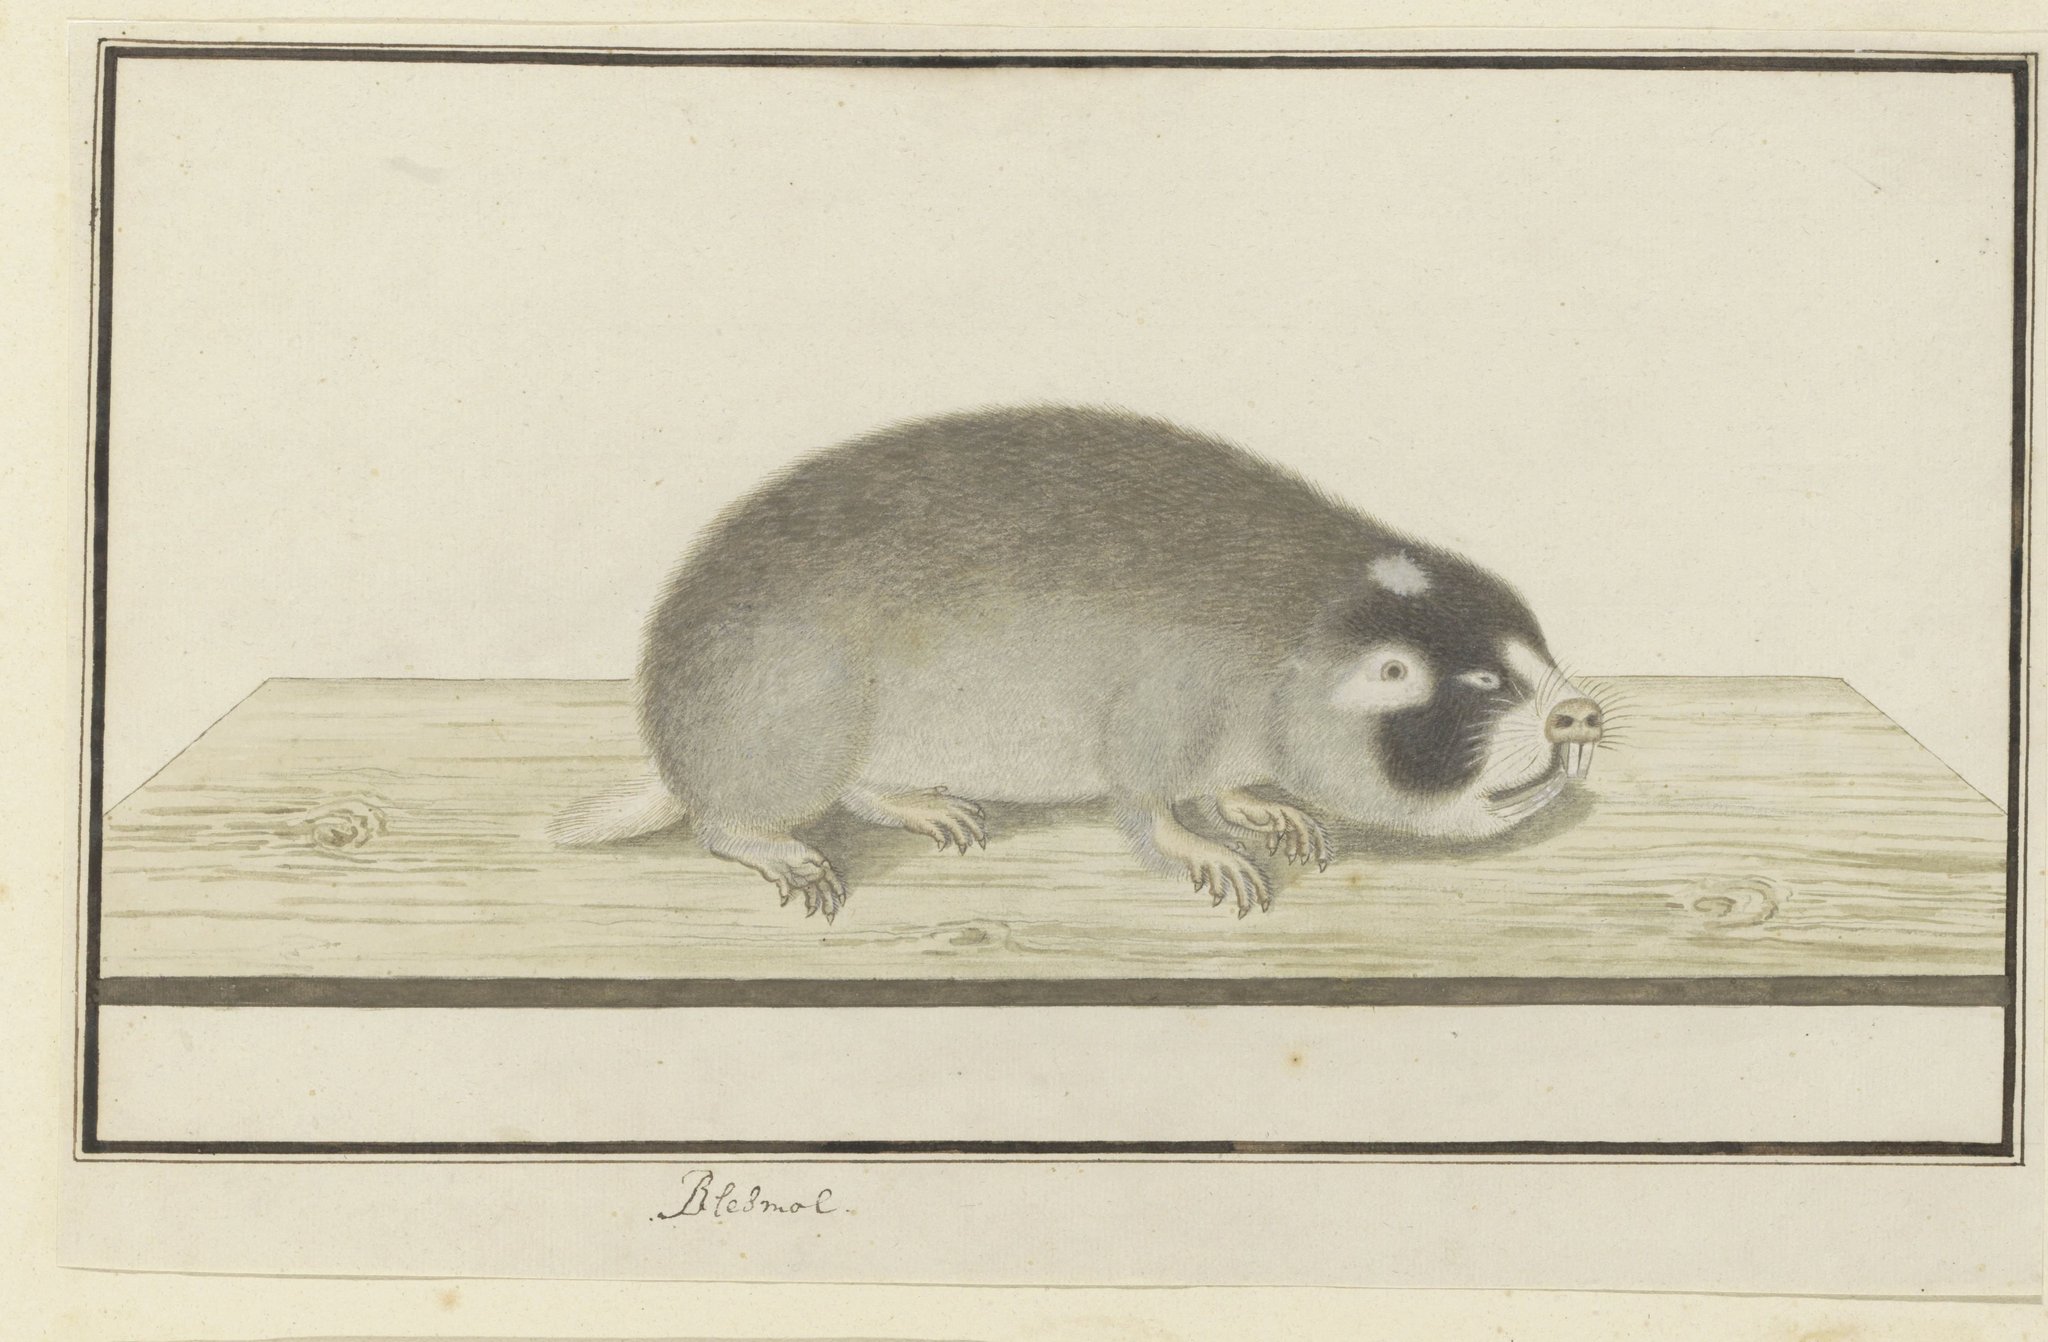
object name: drawing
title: Georychus capensis (Cape mole-rat)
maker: robert jacob gordon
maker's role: draughtsman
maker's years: 1743-1795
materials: paint, ink, paper, pencil, watercolor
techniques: brush, pen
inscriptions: annotation: ‘Blesmol.’